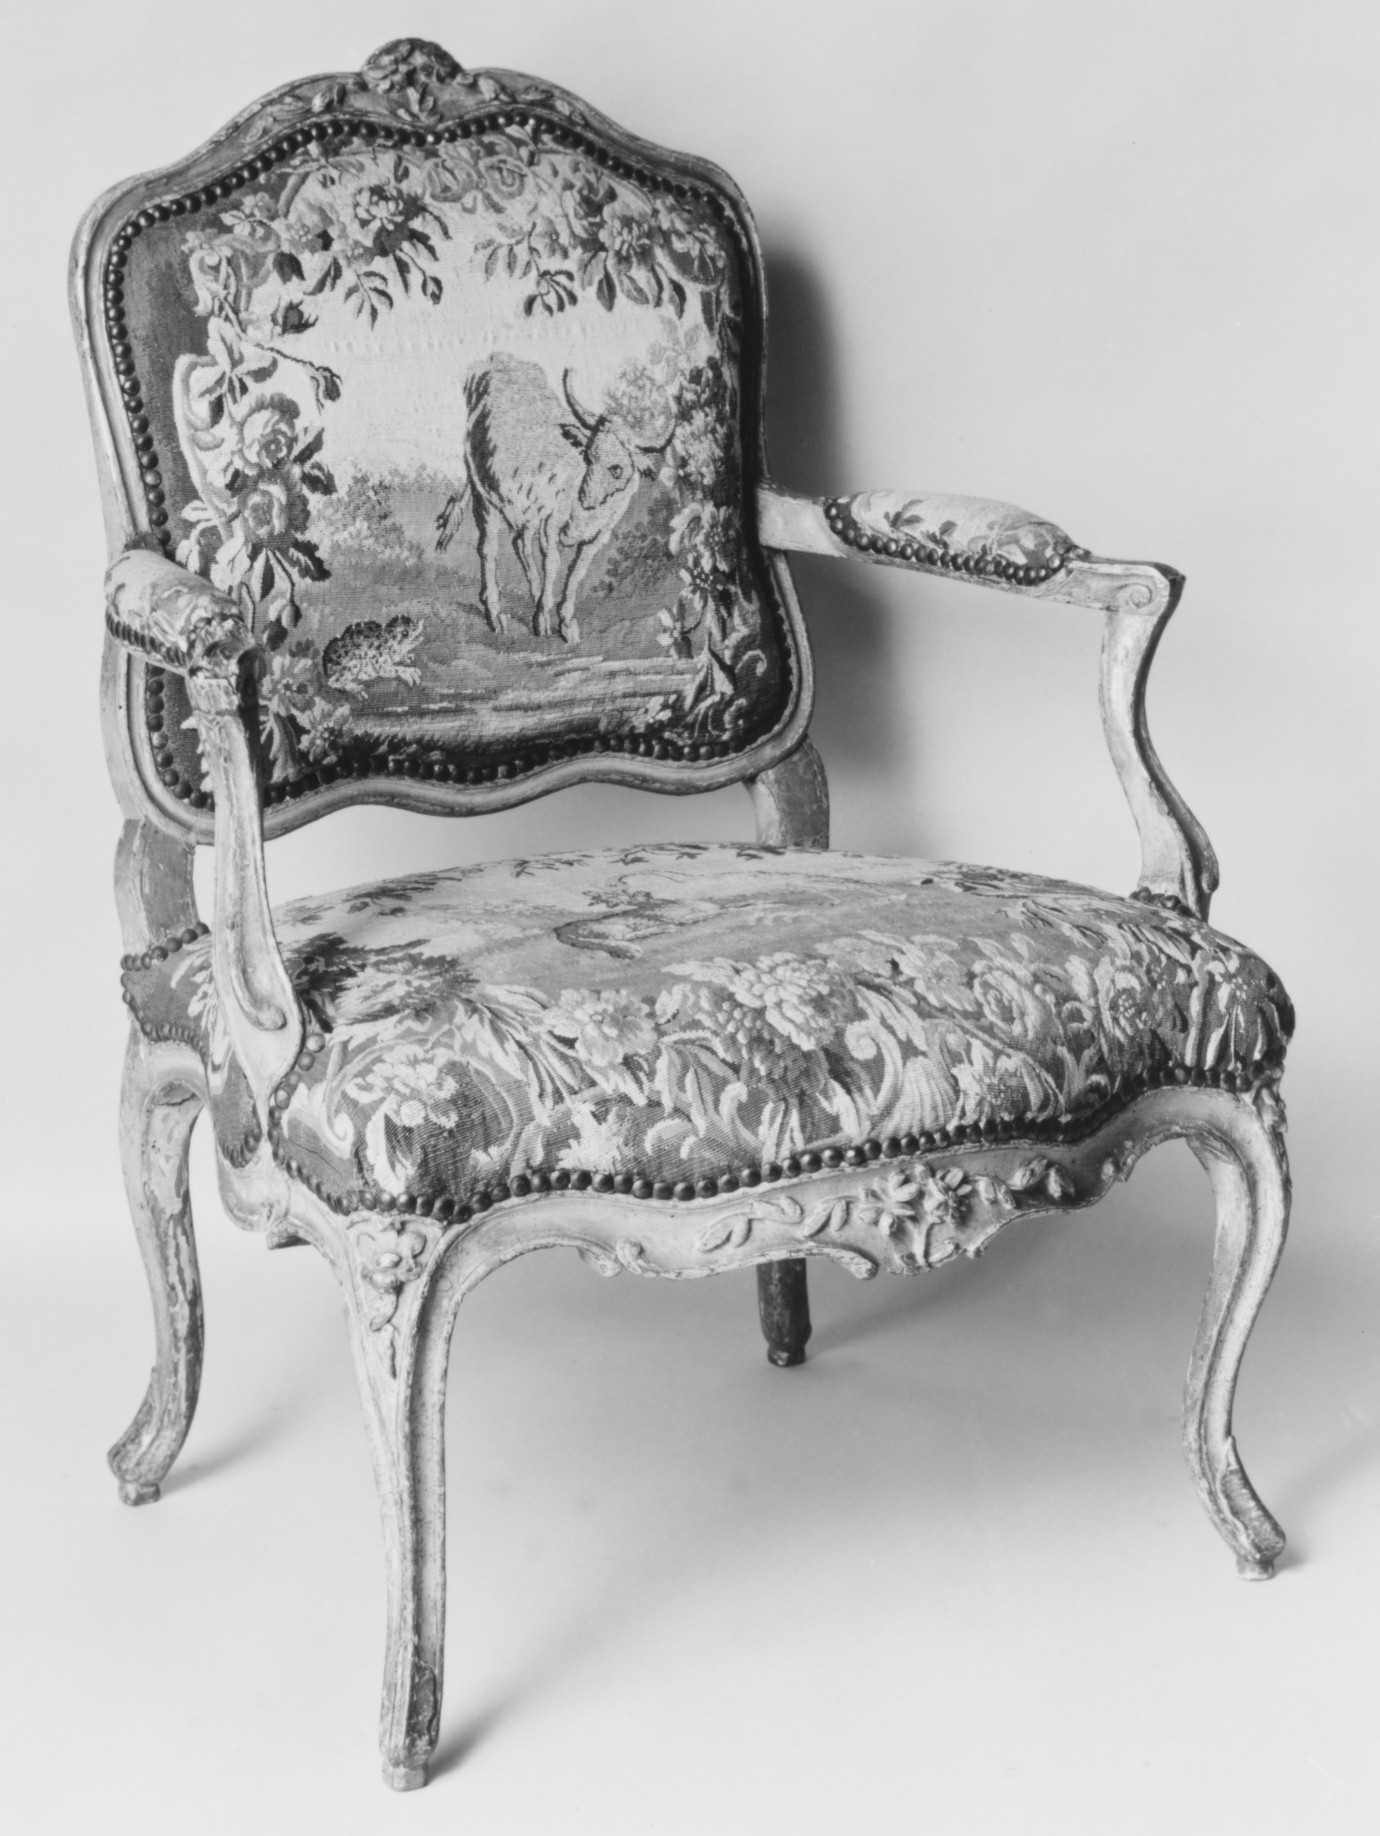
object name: armchair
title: Armchair (part of a set of nine)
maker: aubusson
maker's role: factory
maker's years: 1665-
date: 1734-1766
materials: wood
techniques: carving, painting, tapestry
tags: cranes,cows,foxes,flowers